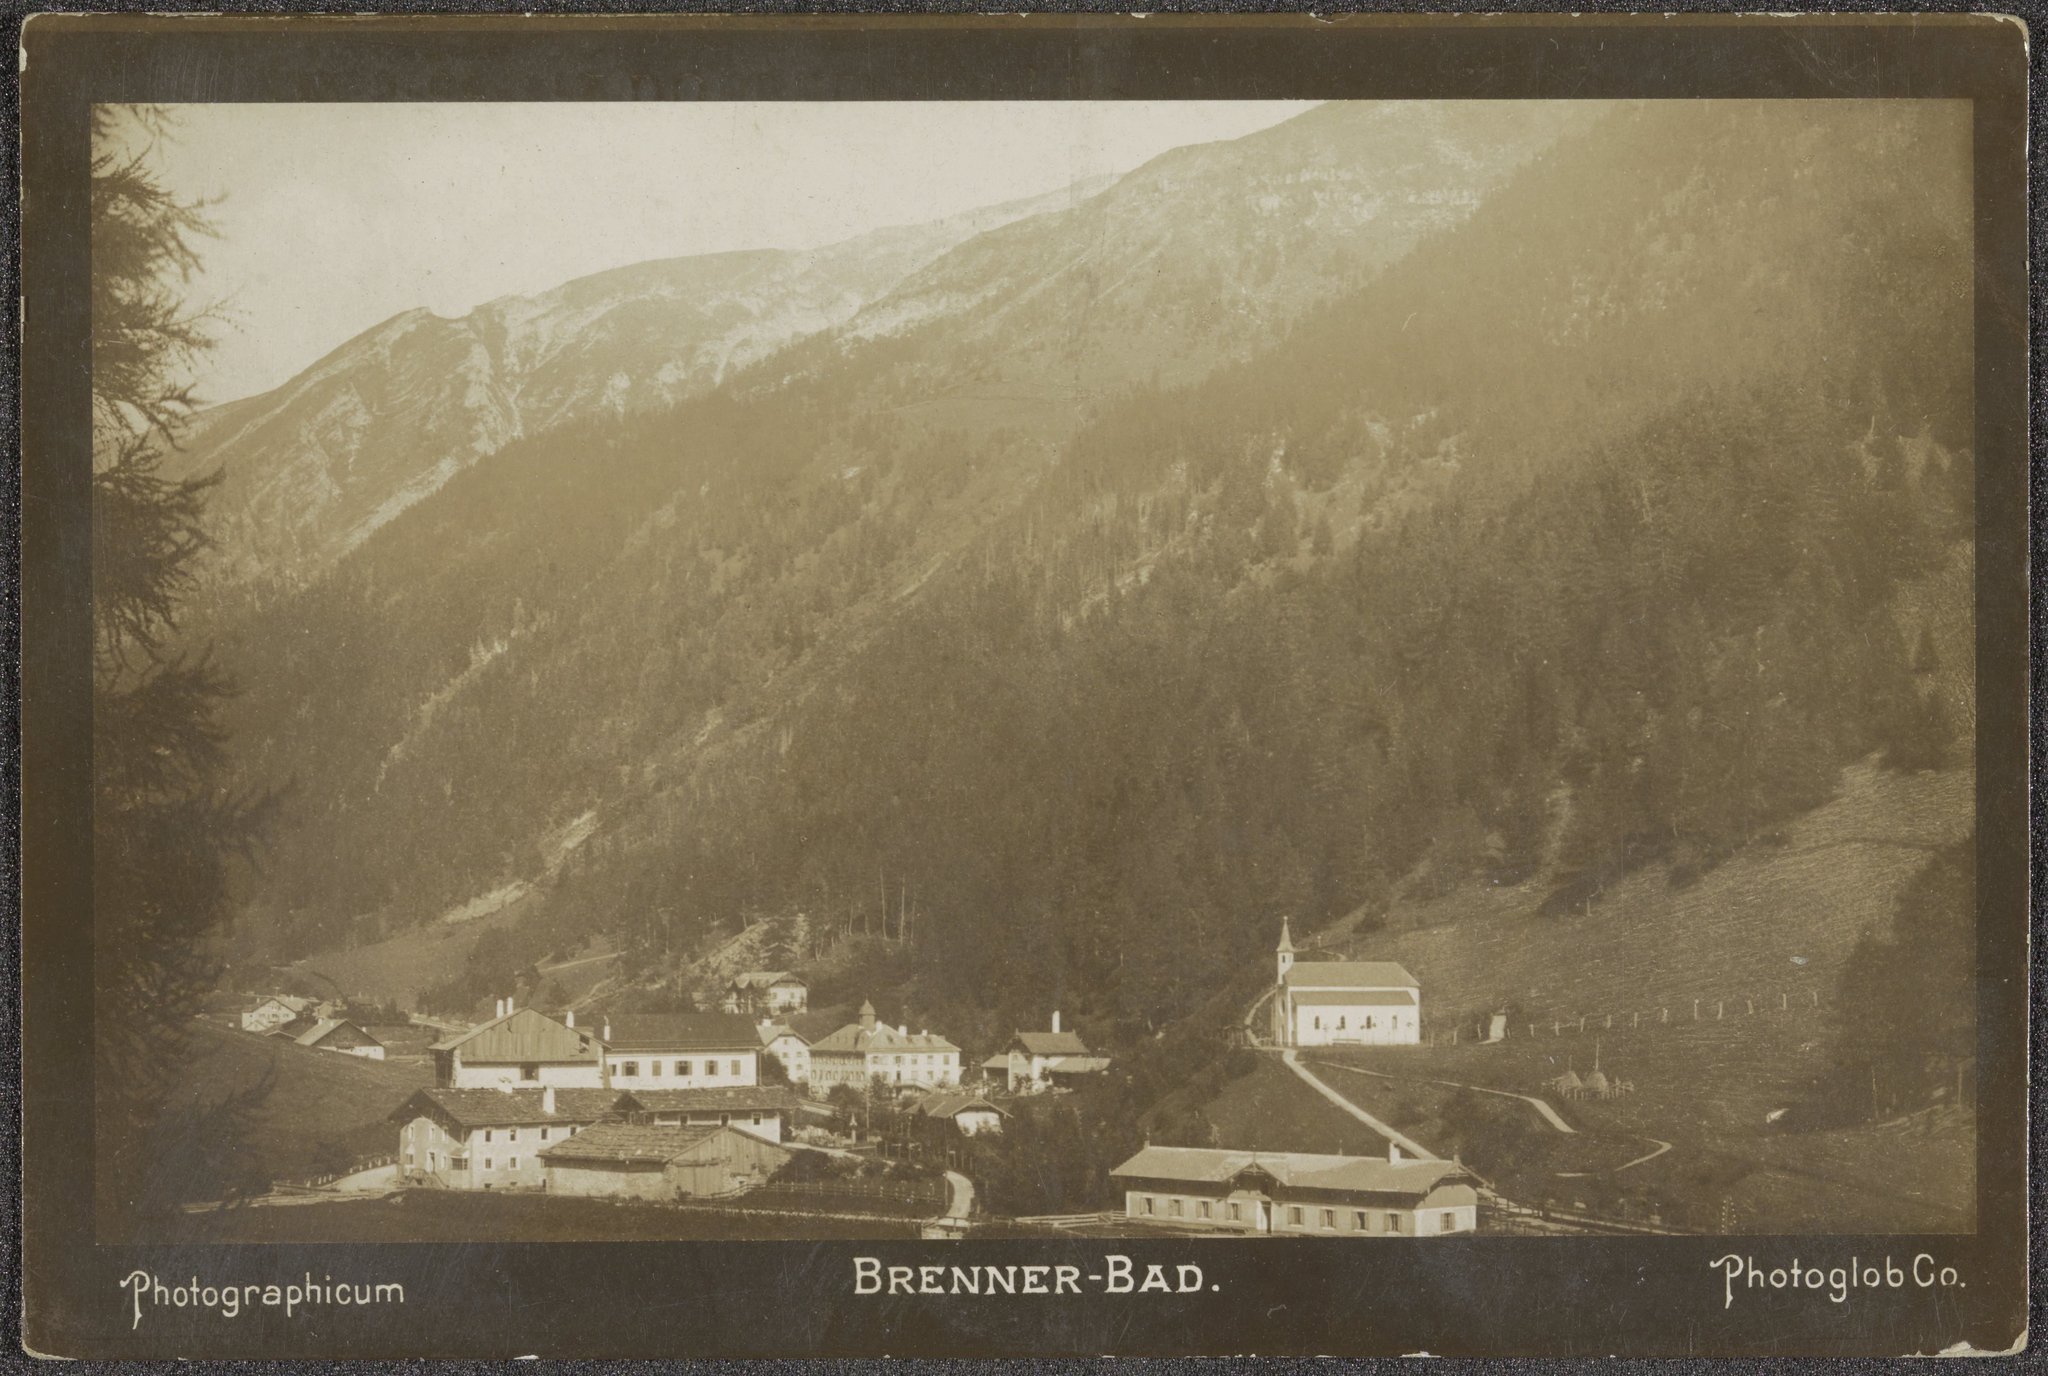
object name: photograph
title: Brenner-Bad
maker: Anonymous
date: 1870-1898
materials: photographic support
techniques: gelatin silver print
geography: terme del brennero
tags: prospect of village, silhouette of village, travelling; tourism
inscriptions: name: ‘Gebroeders Dobbelmann, Zeepfabrikanten, Nijmegen.’, inscription: ‘Photographicum’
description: Foto hoort bij een serie van 28 losse prentbriefkaarten van Engeland, Noorwegen, Italië, Duitsland en Tirol (foto's RP-F-F00945-1 t/m RP-F-F00945-28).